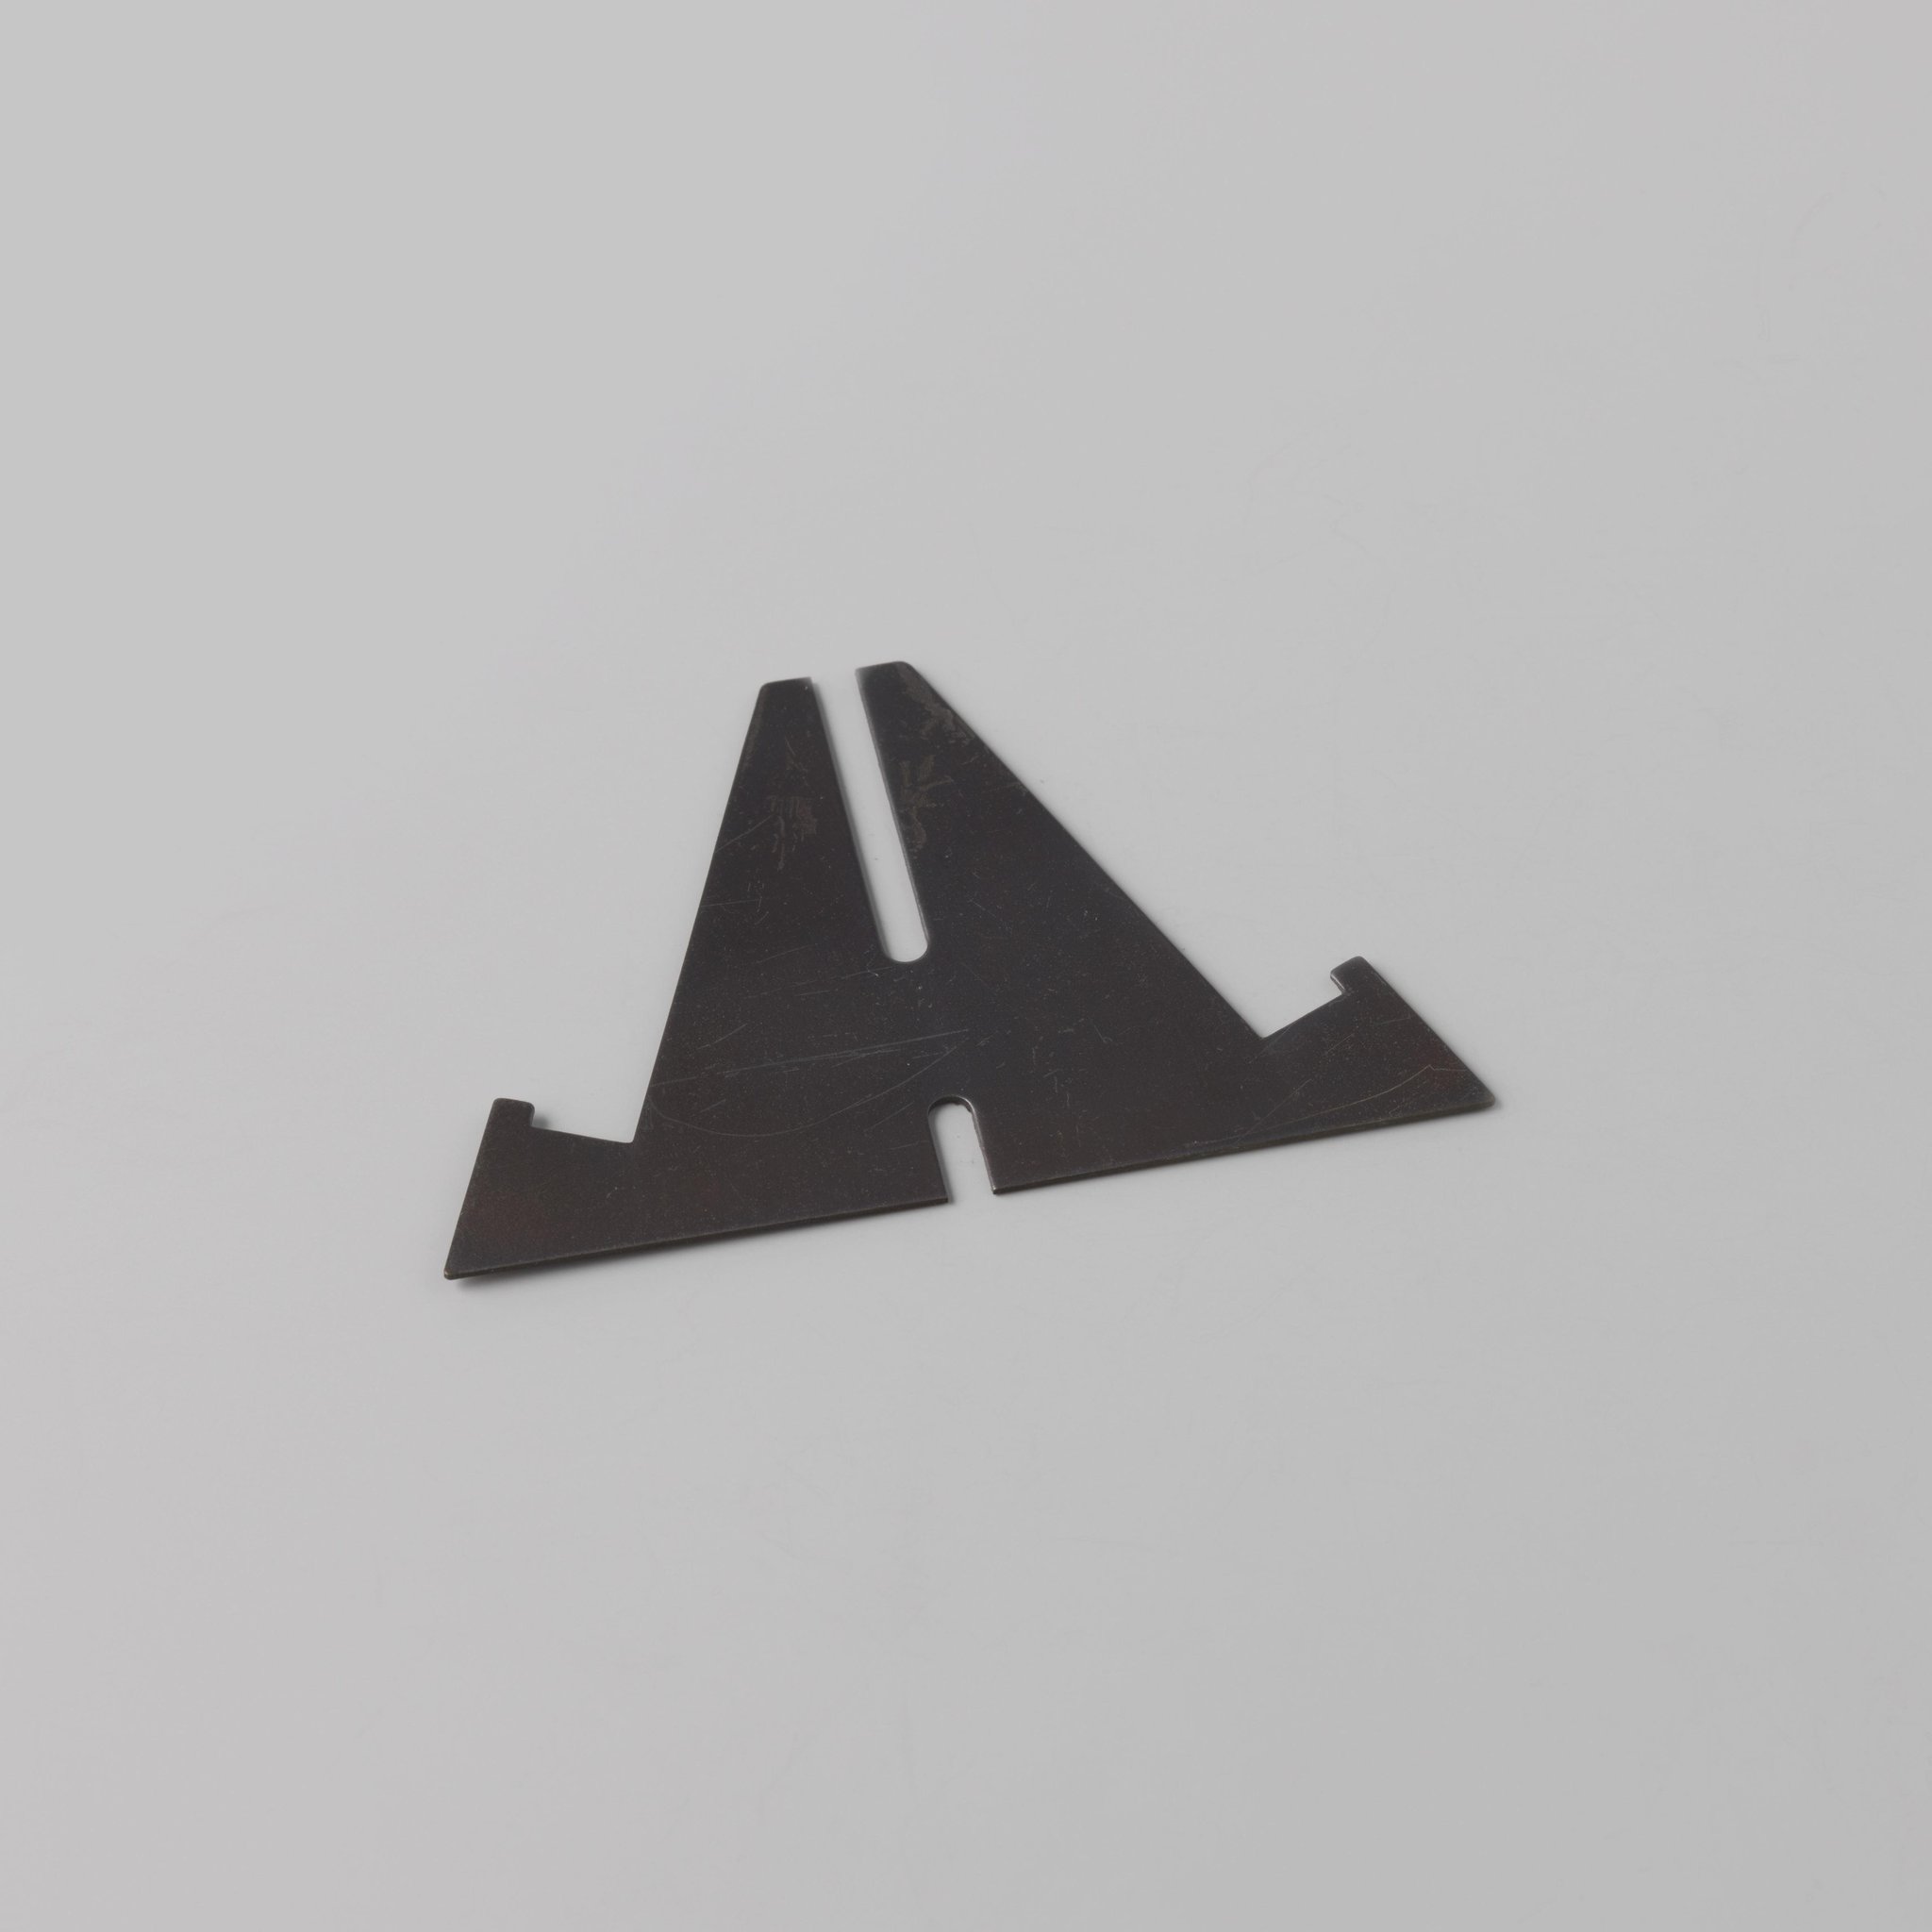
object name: steun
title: Steun behorend bij een bronzen penning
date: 1950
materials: metal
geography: zoetermeer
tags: djatiroto, suikeronderneming, handels vereeniging amsterdam, jatiroto, malang, tweede wereldoorlog, nederlandse militaire acties in indonesië (1945-1949)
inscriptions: inscription: ‘QUO PATET ORBIS’, inscription: ‘AANGEBODEN DOOR DE N.V. HANDELSVEREENIGING "AMSTERDAM" TER HERINNERING AAN DE BEVRIJDING VAN DE SUIKERFABRIEK DJATIROTO 22 JULI 1947’, inscription: ‘JE MAINTIENDRAI’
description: Metalen steuntje behorend bij een bronzen penning.